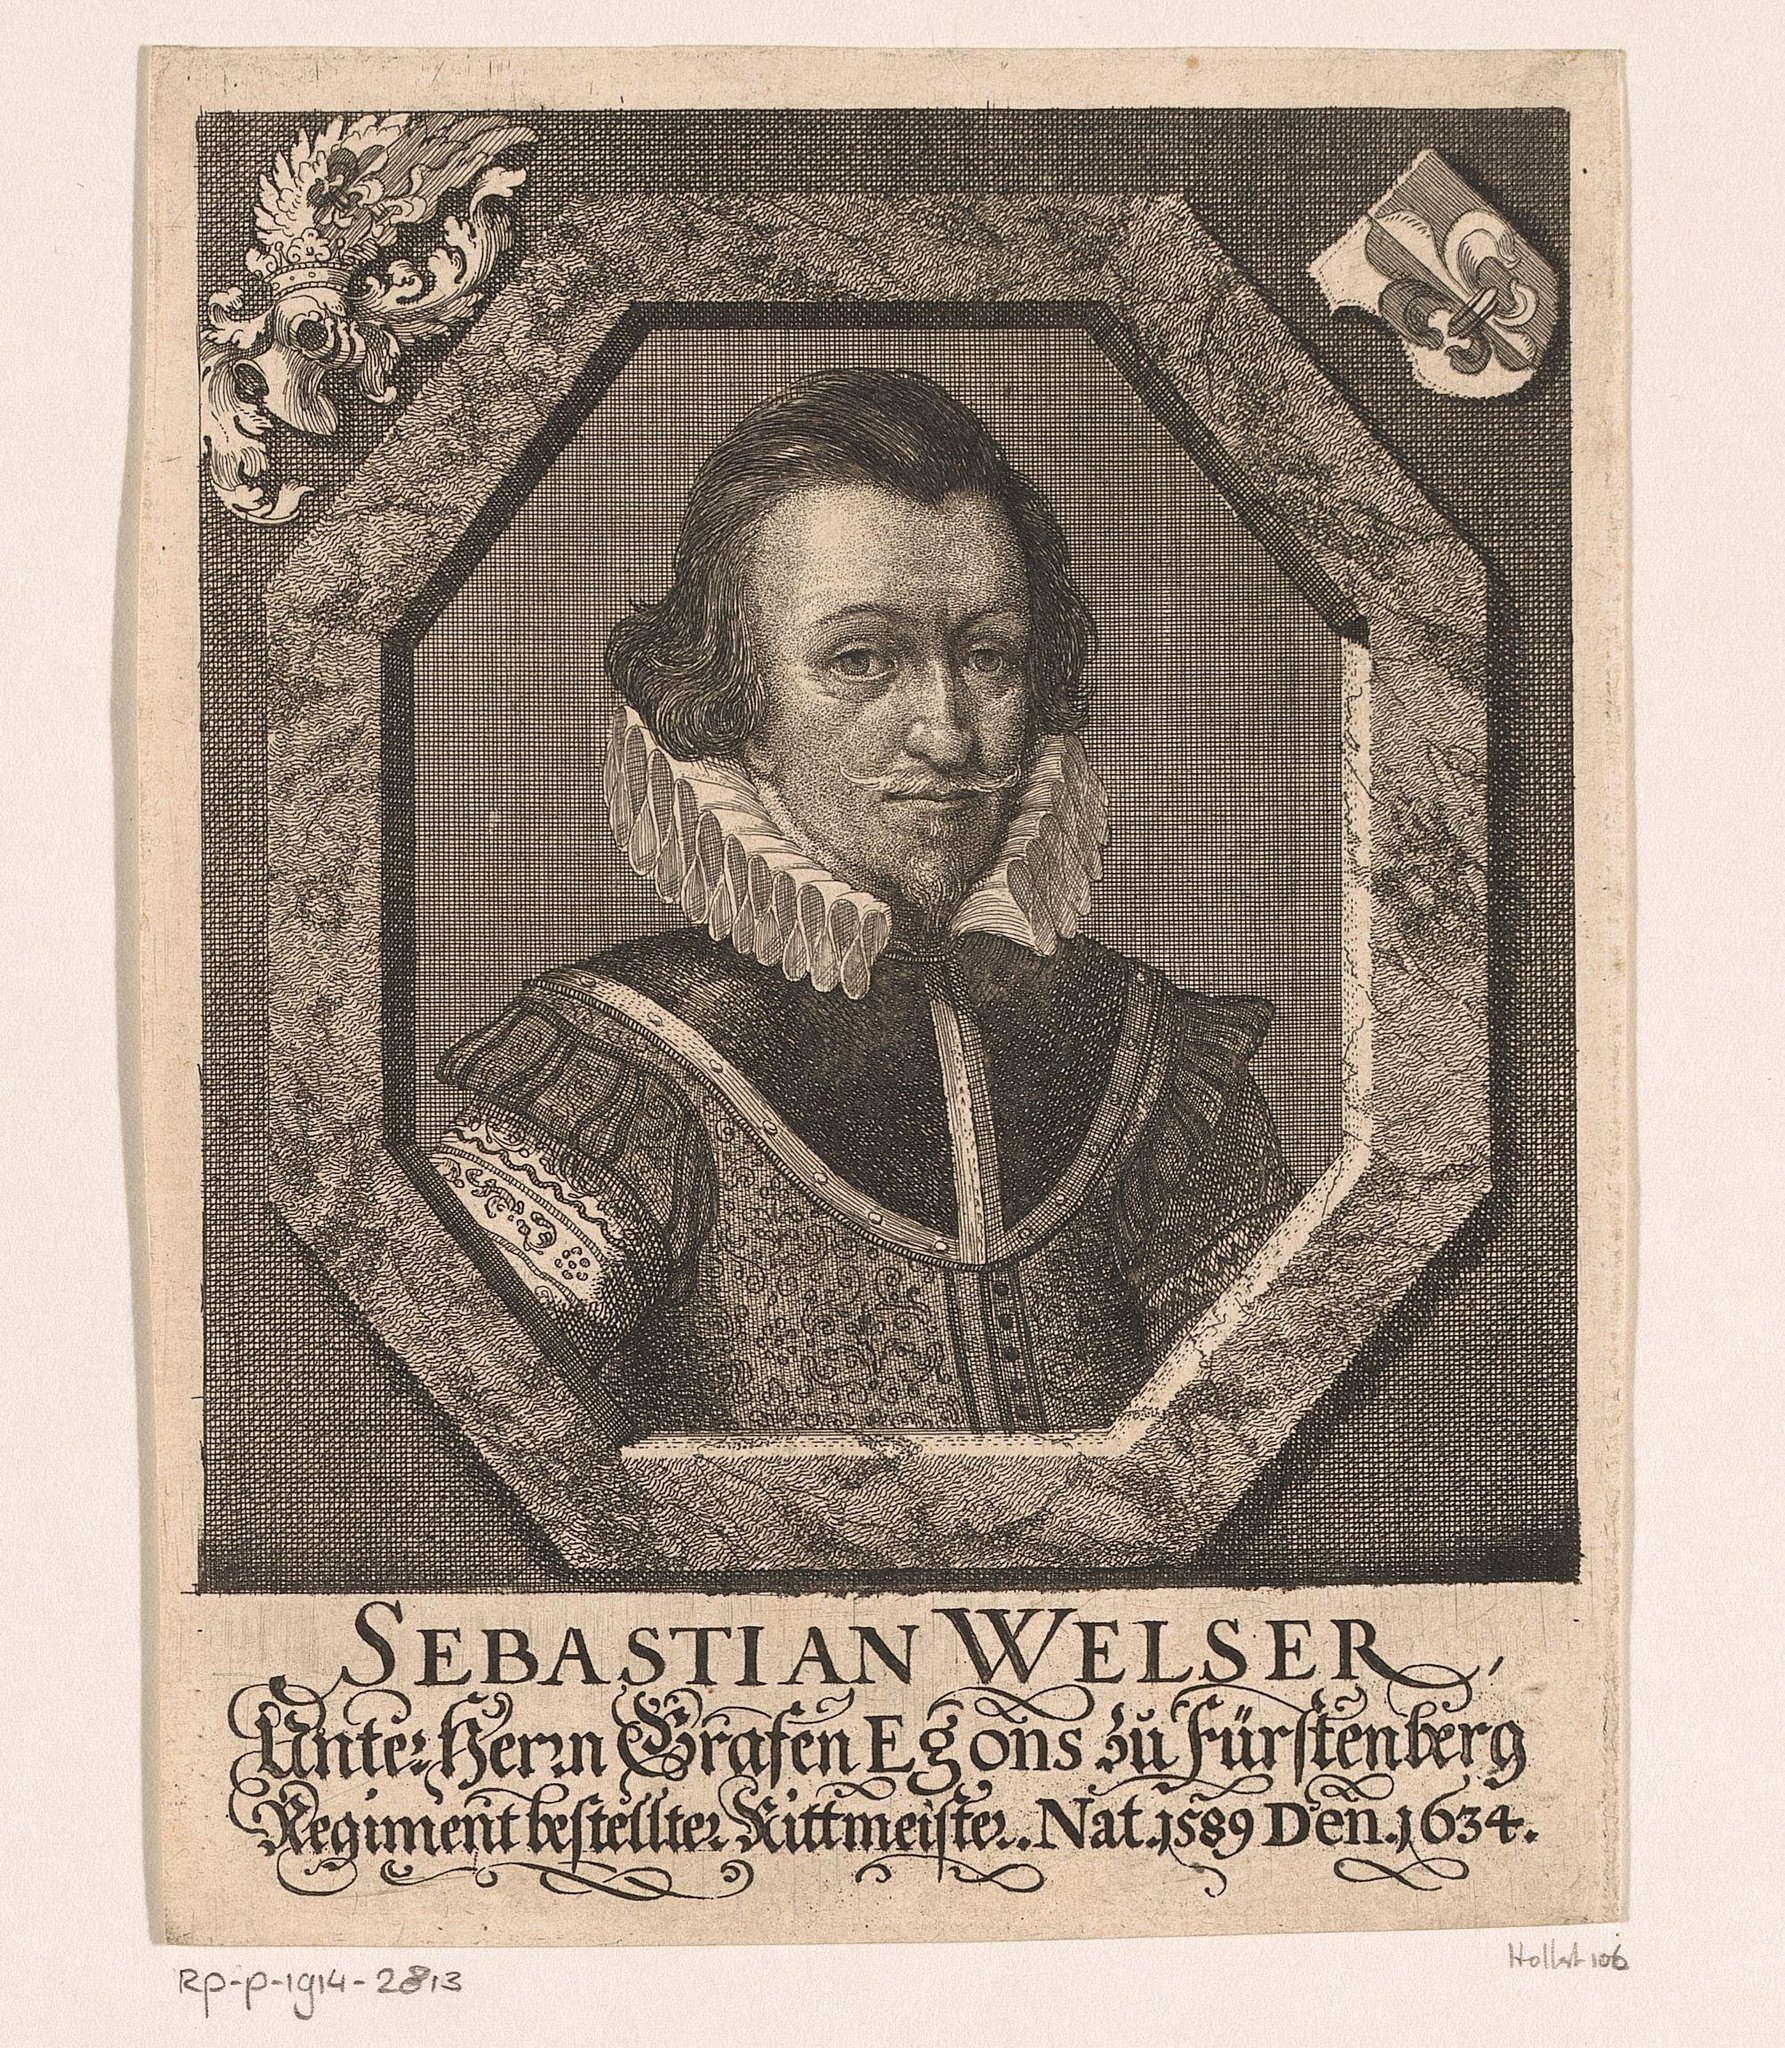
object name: print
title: Portret van Sebastian Welser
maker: georg christoph eimmart (ii)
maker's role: print maker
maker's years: 1638-1705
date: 1648-1705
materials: paper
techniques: etching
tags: earl, historical persons, armorial bearing, heraldry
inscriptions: collector's mark: Lugt 2228